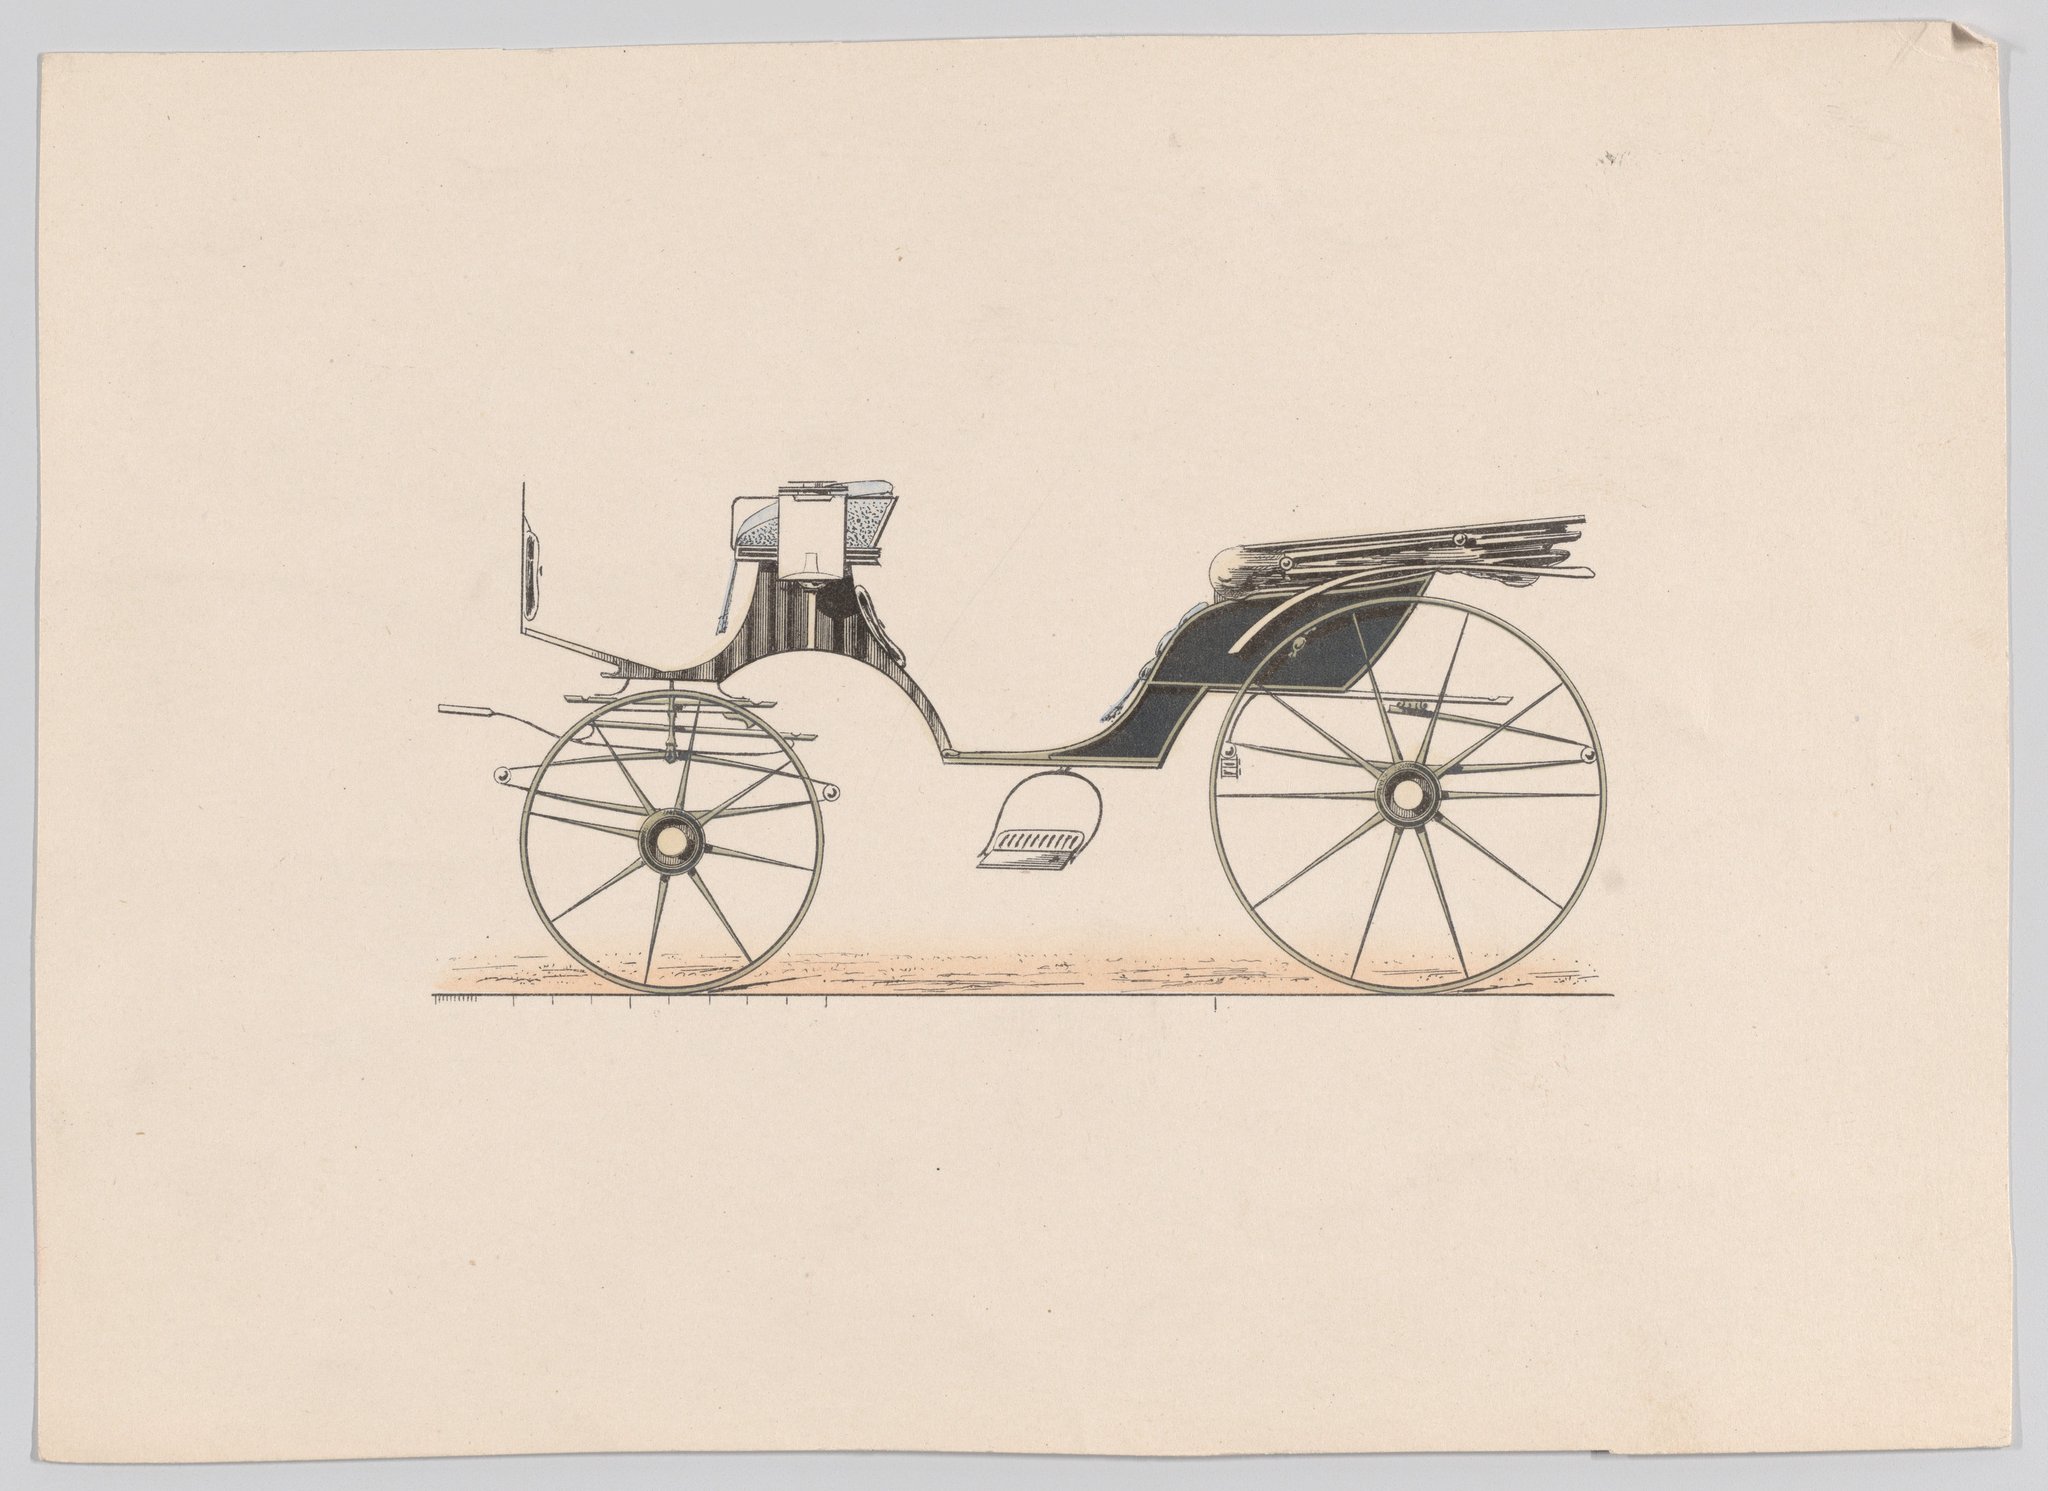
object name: print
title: Design for Cabriolet Carriage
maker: anonymous, french, 19th century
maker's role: artist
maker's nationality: french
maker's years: 1800-1900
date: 1880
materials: gum arabic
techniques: lithograph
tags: carriages